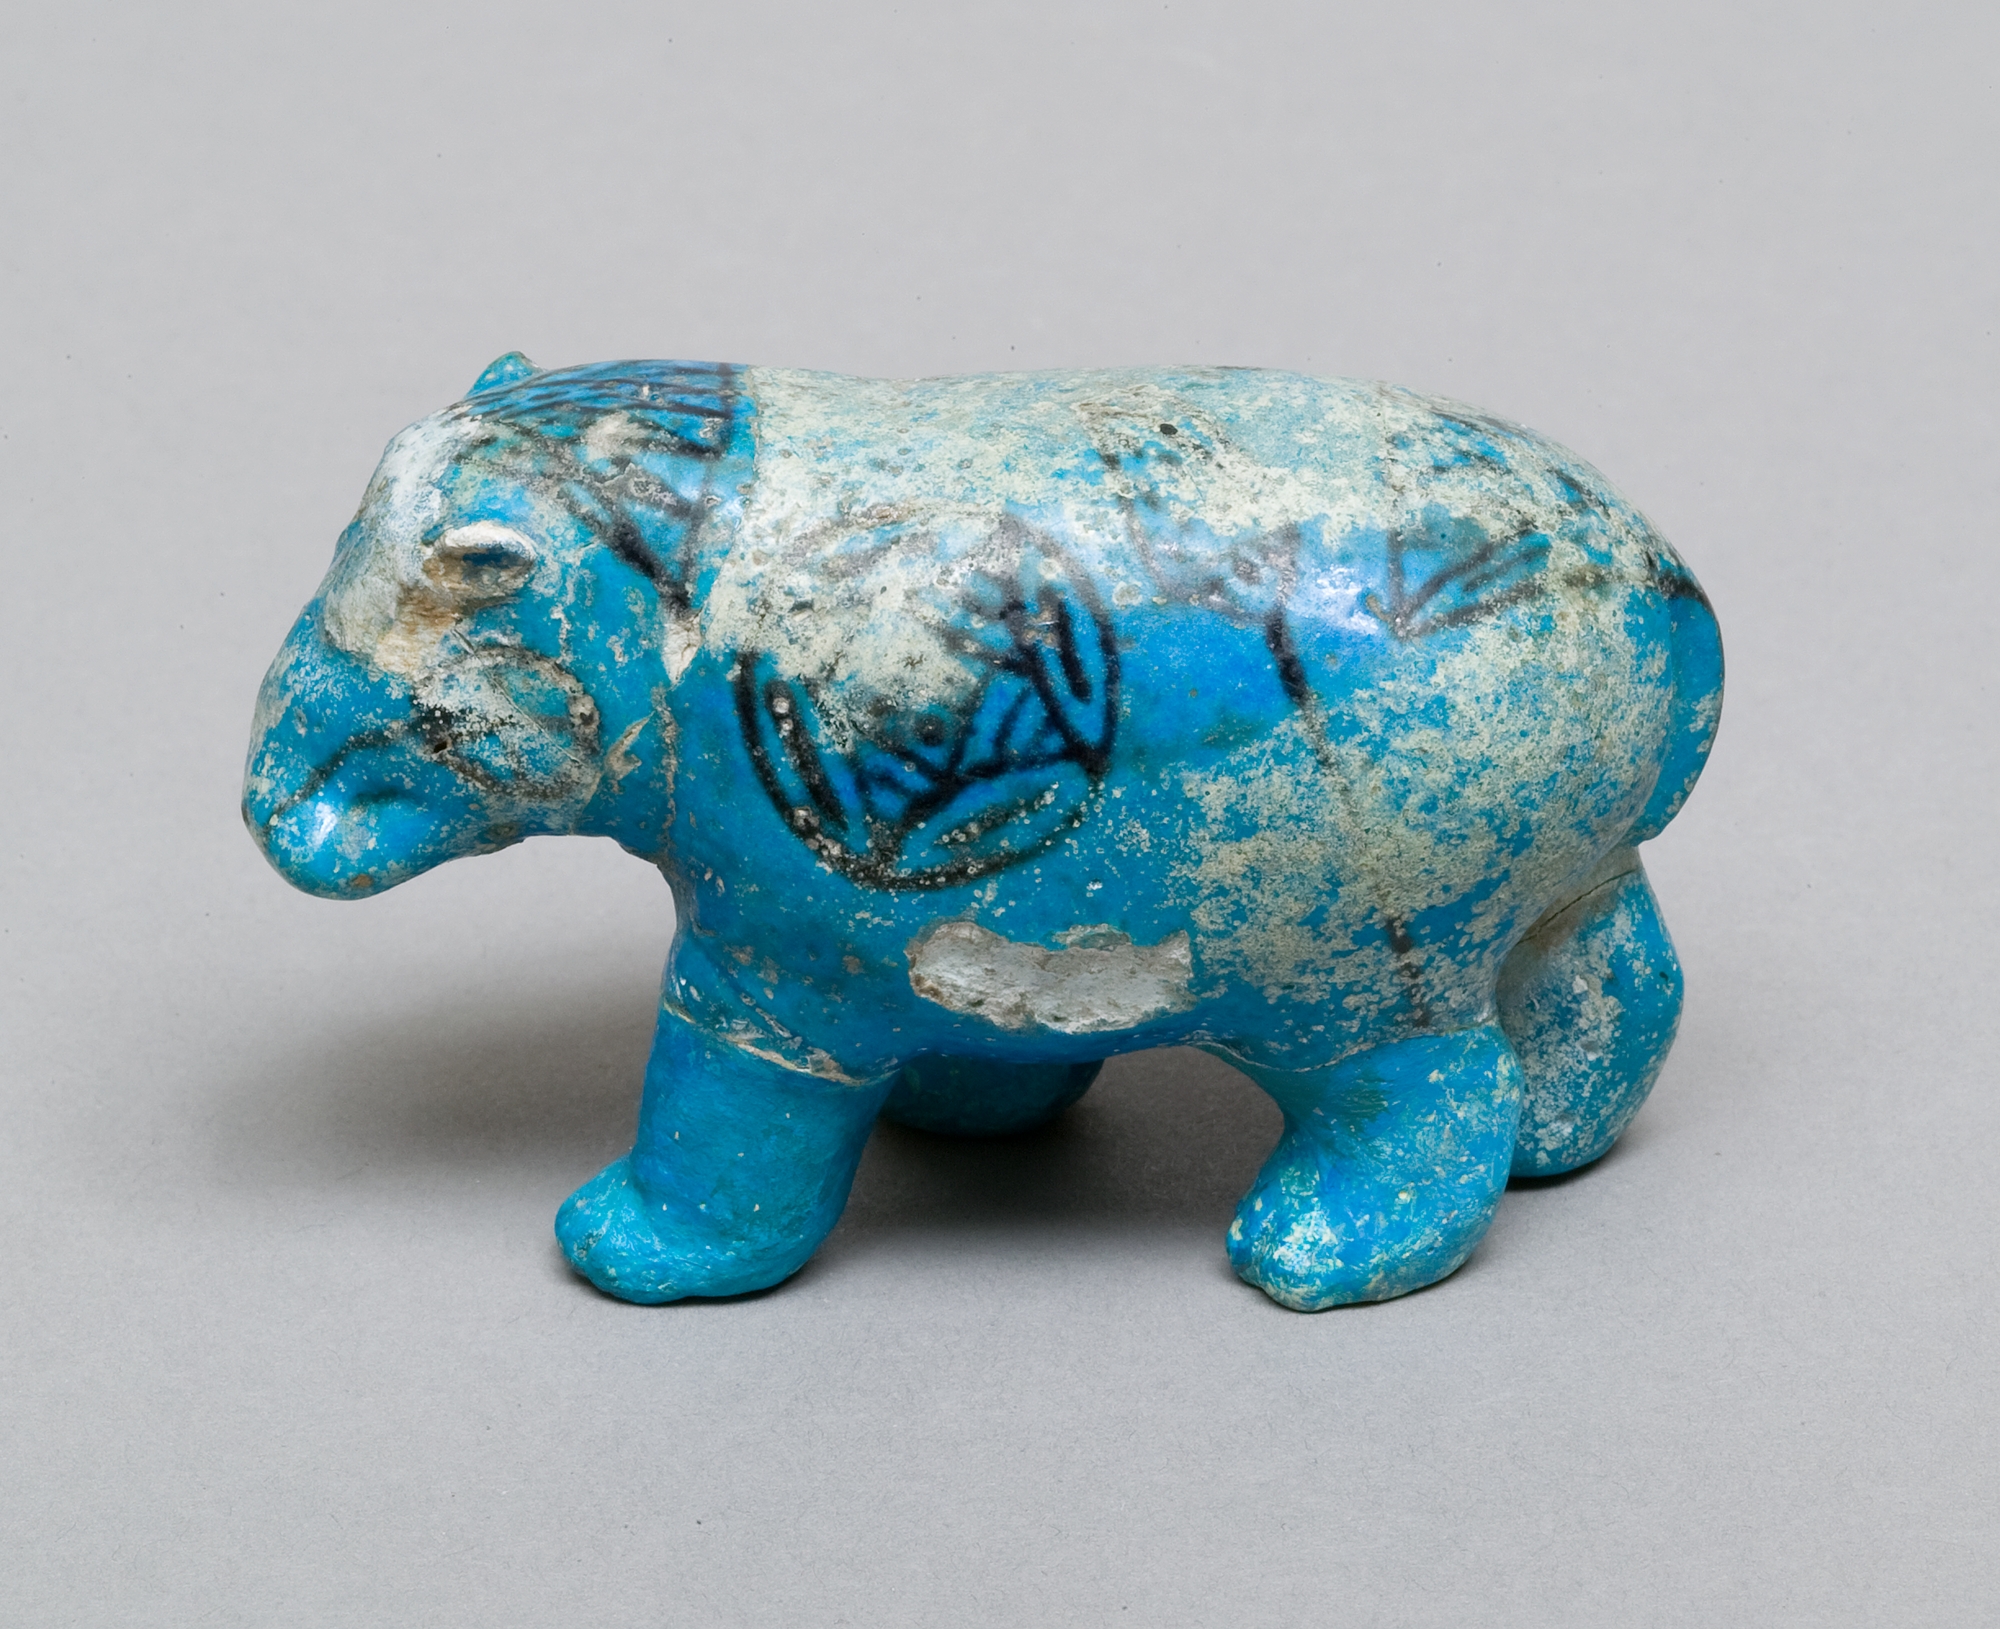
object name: figurine, hippopotamus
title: Hippopotamus figurine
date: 1981-1640 BCE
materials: faience, glaze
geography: egypt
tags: hippos